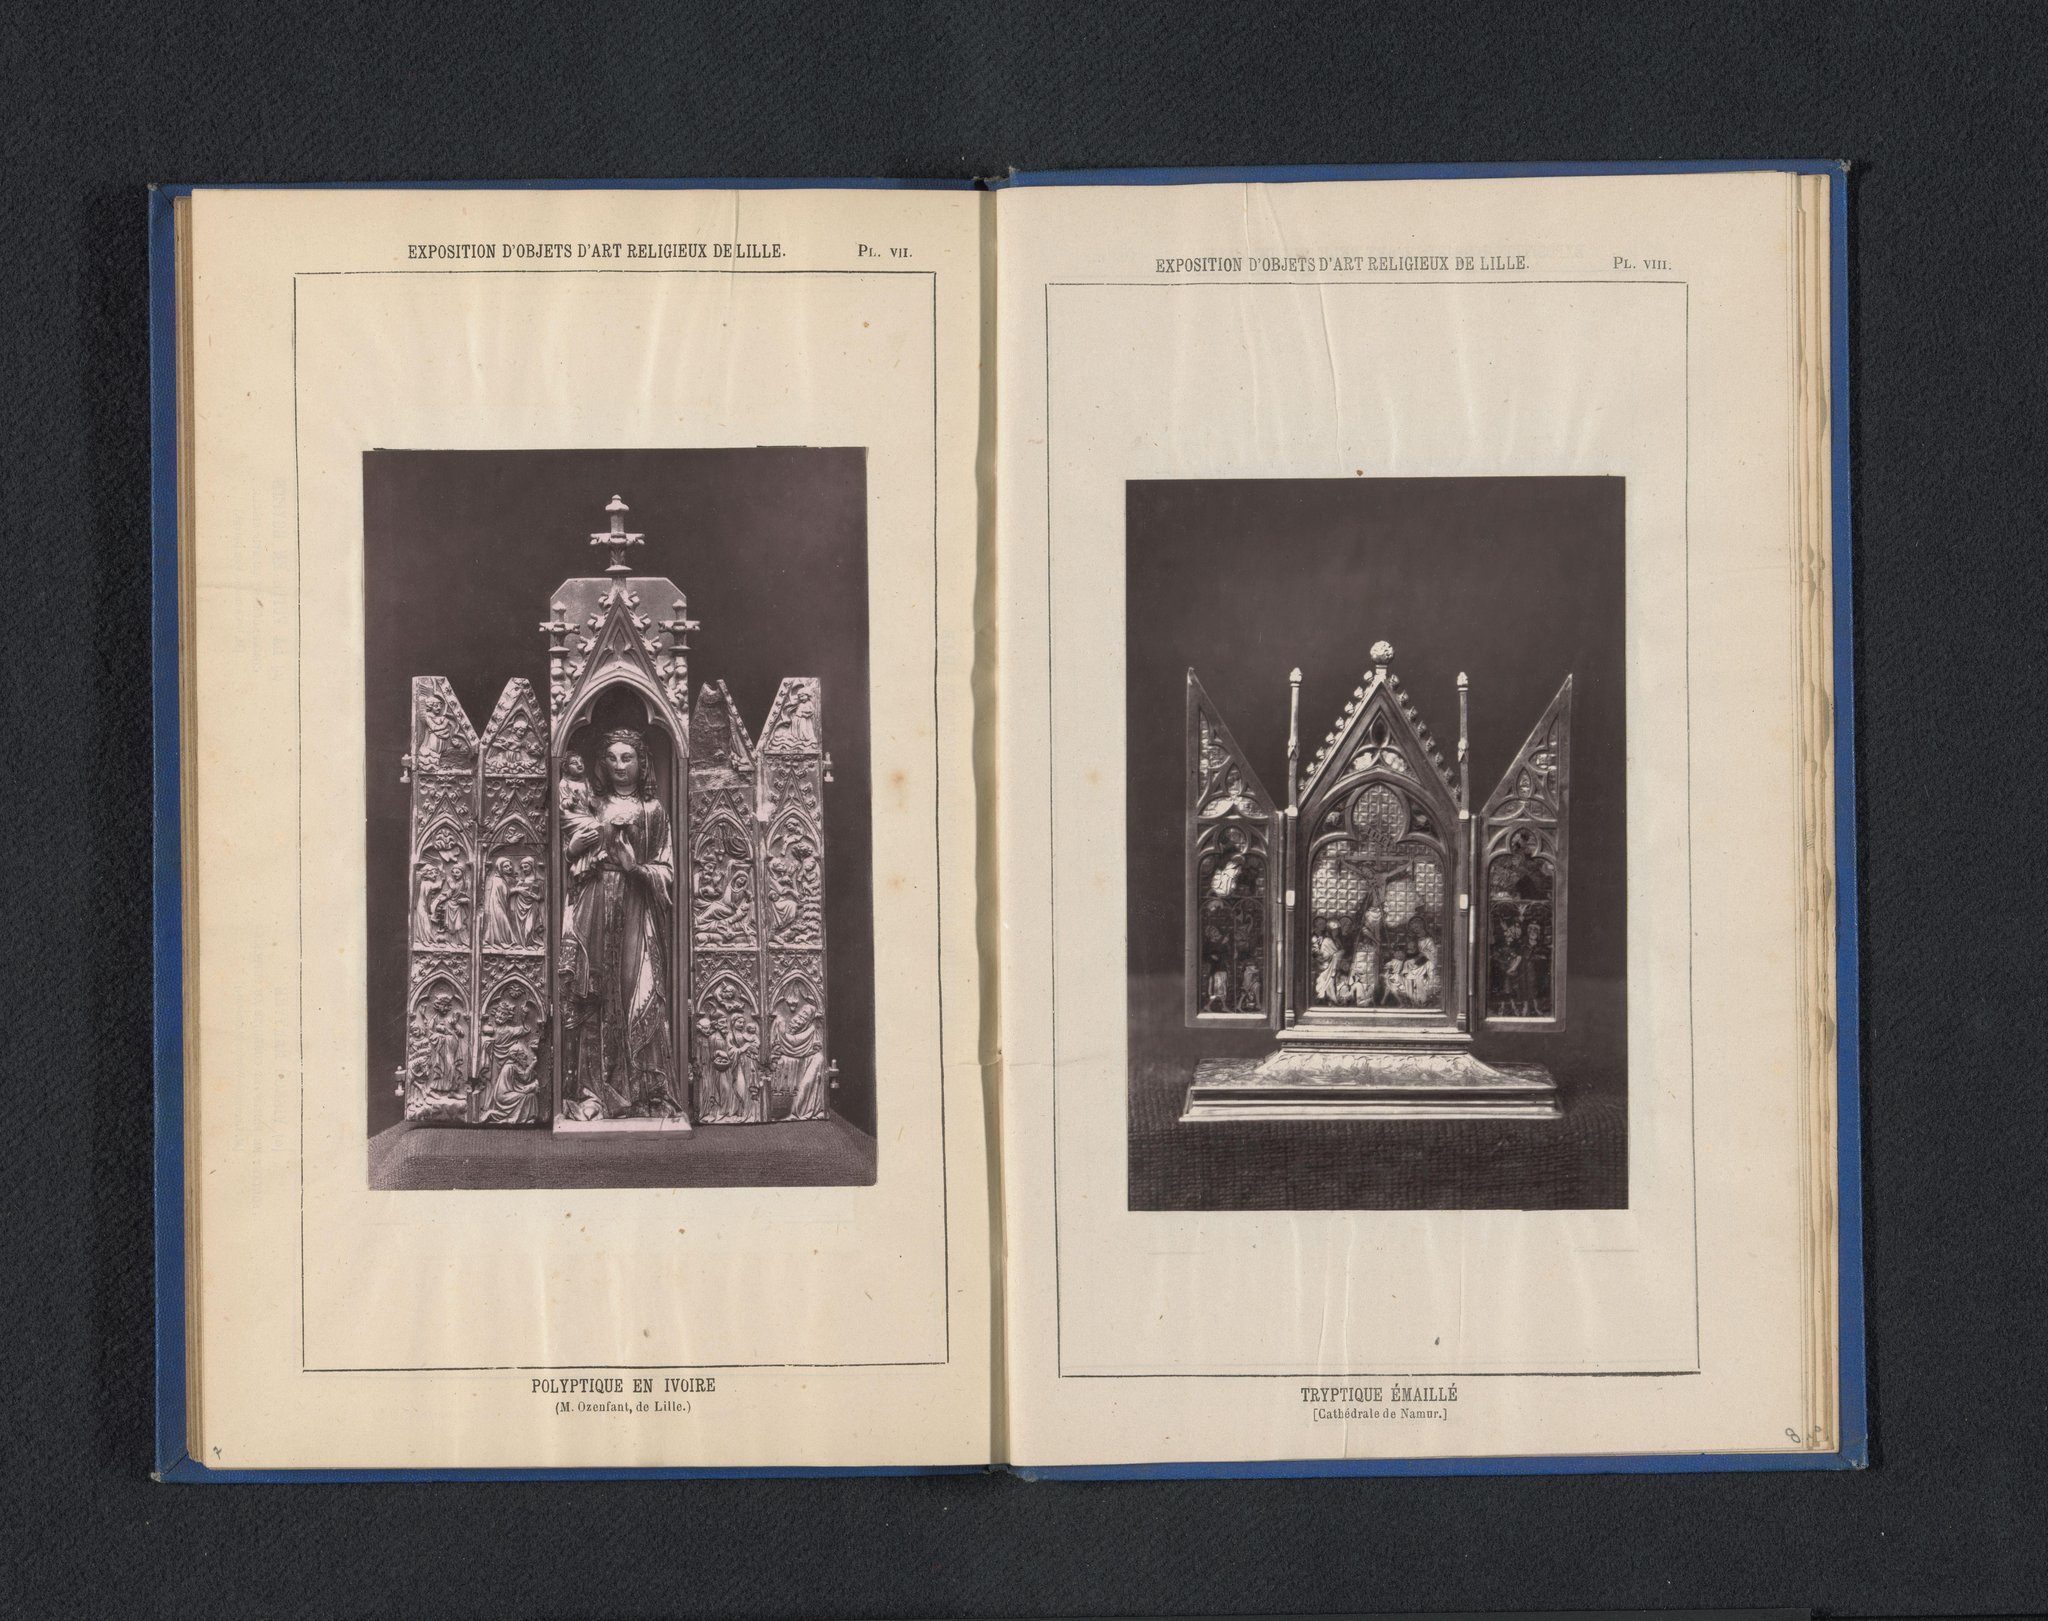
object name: page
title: Polyptiek van ivoor met Maria met kind en verschillende religieuze voorstellingen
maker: Anonymous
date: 1871-1876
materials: cardboard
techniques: woodburytype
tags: madonna: i.e. mary with the christ-child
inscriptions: inscription: ‘Pl. VII.’, inscription: ‘Exposition d'objets d'art religieux de Lille’, inscription: ‘M. Ozenfant, de Lille’